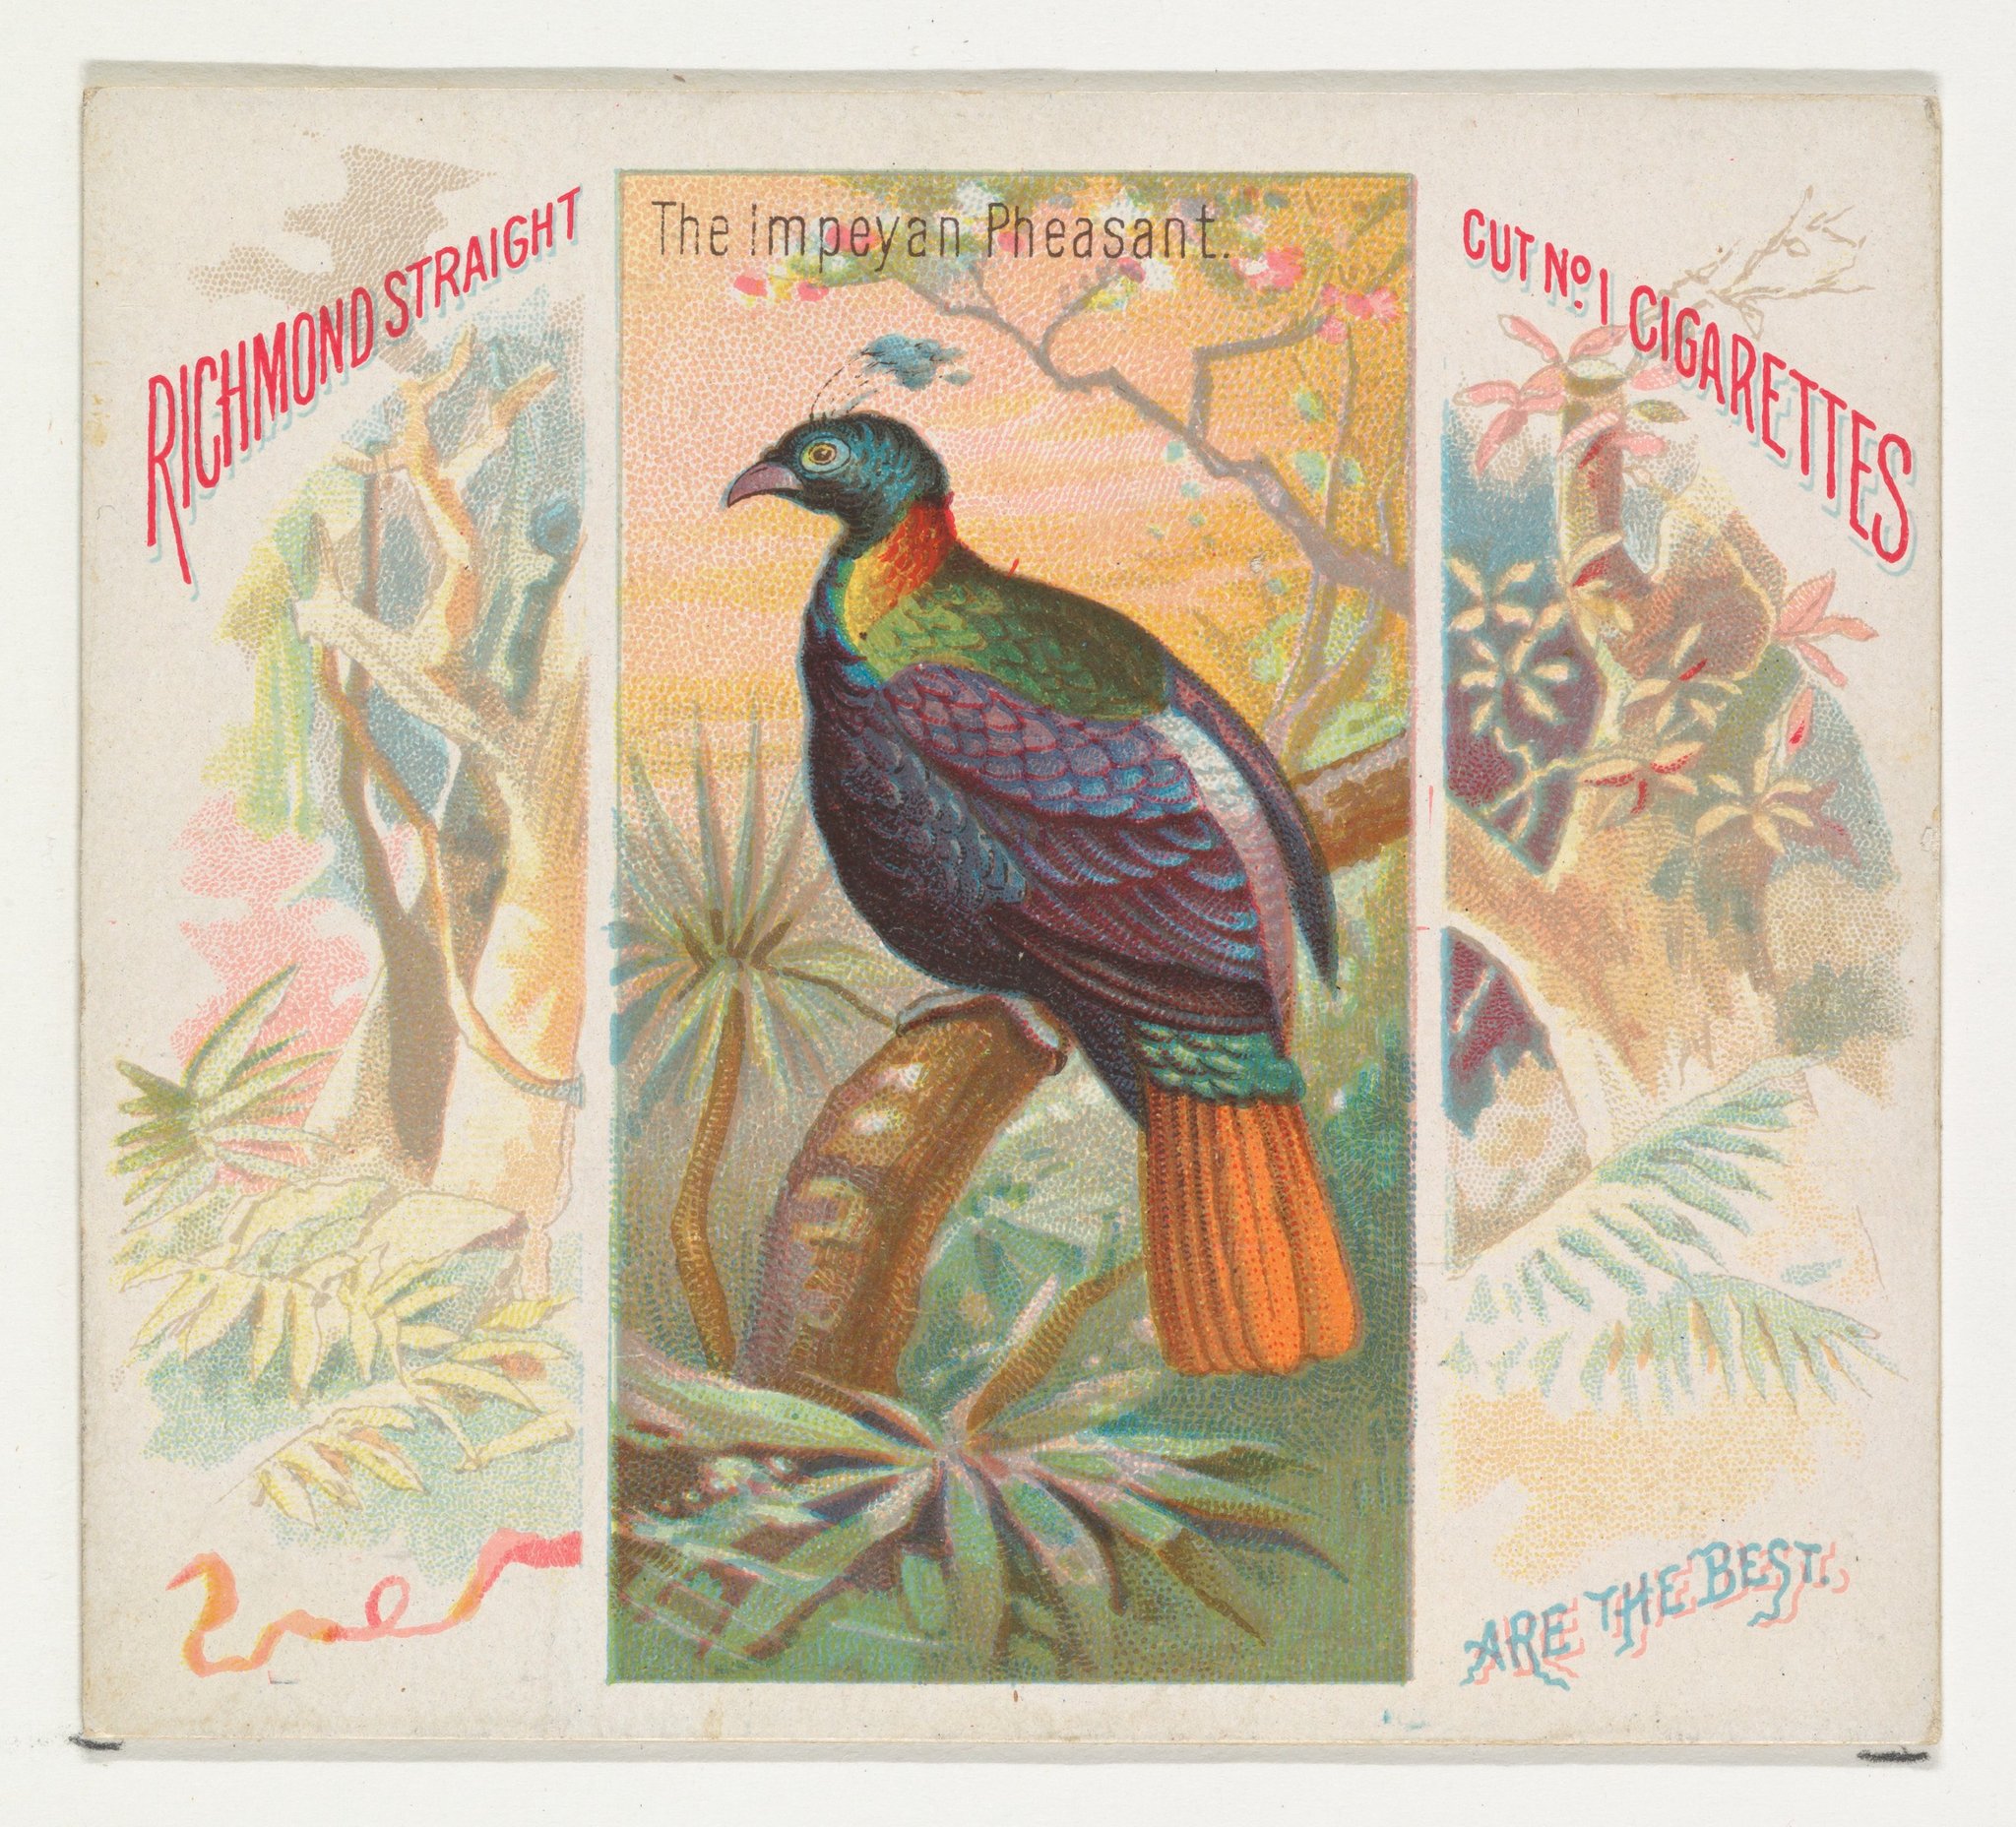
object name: print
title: The Impeyan Pheasant, from Birds of the Tropics series (N38) for Allen & Ginter Cigarettes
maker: allen & ginter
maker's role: publisher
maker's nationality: american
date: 1889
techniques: color lithograph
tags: pheasants